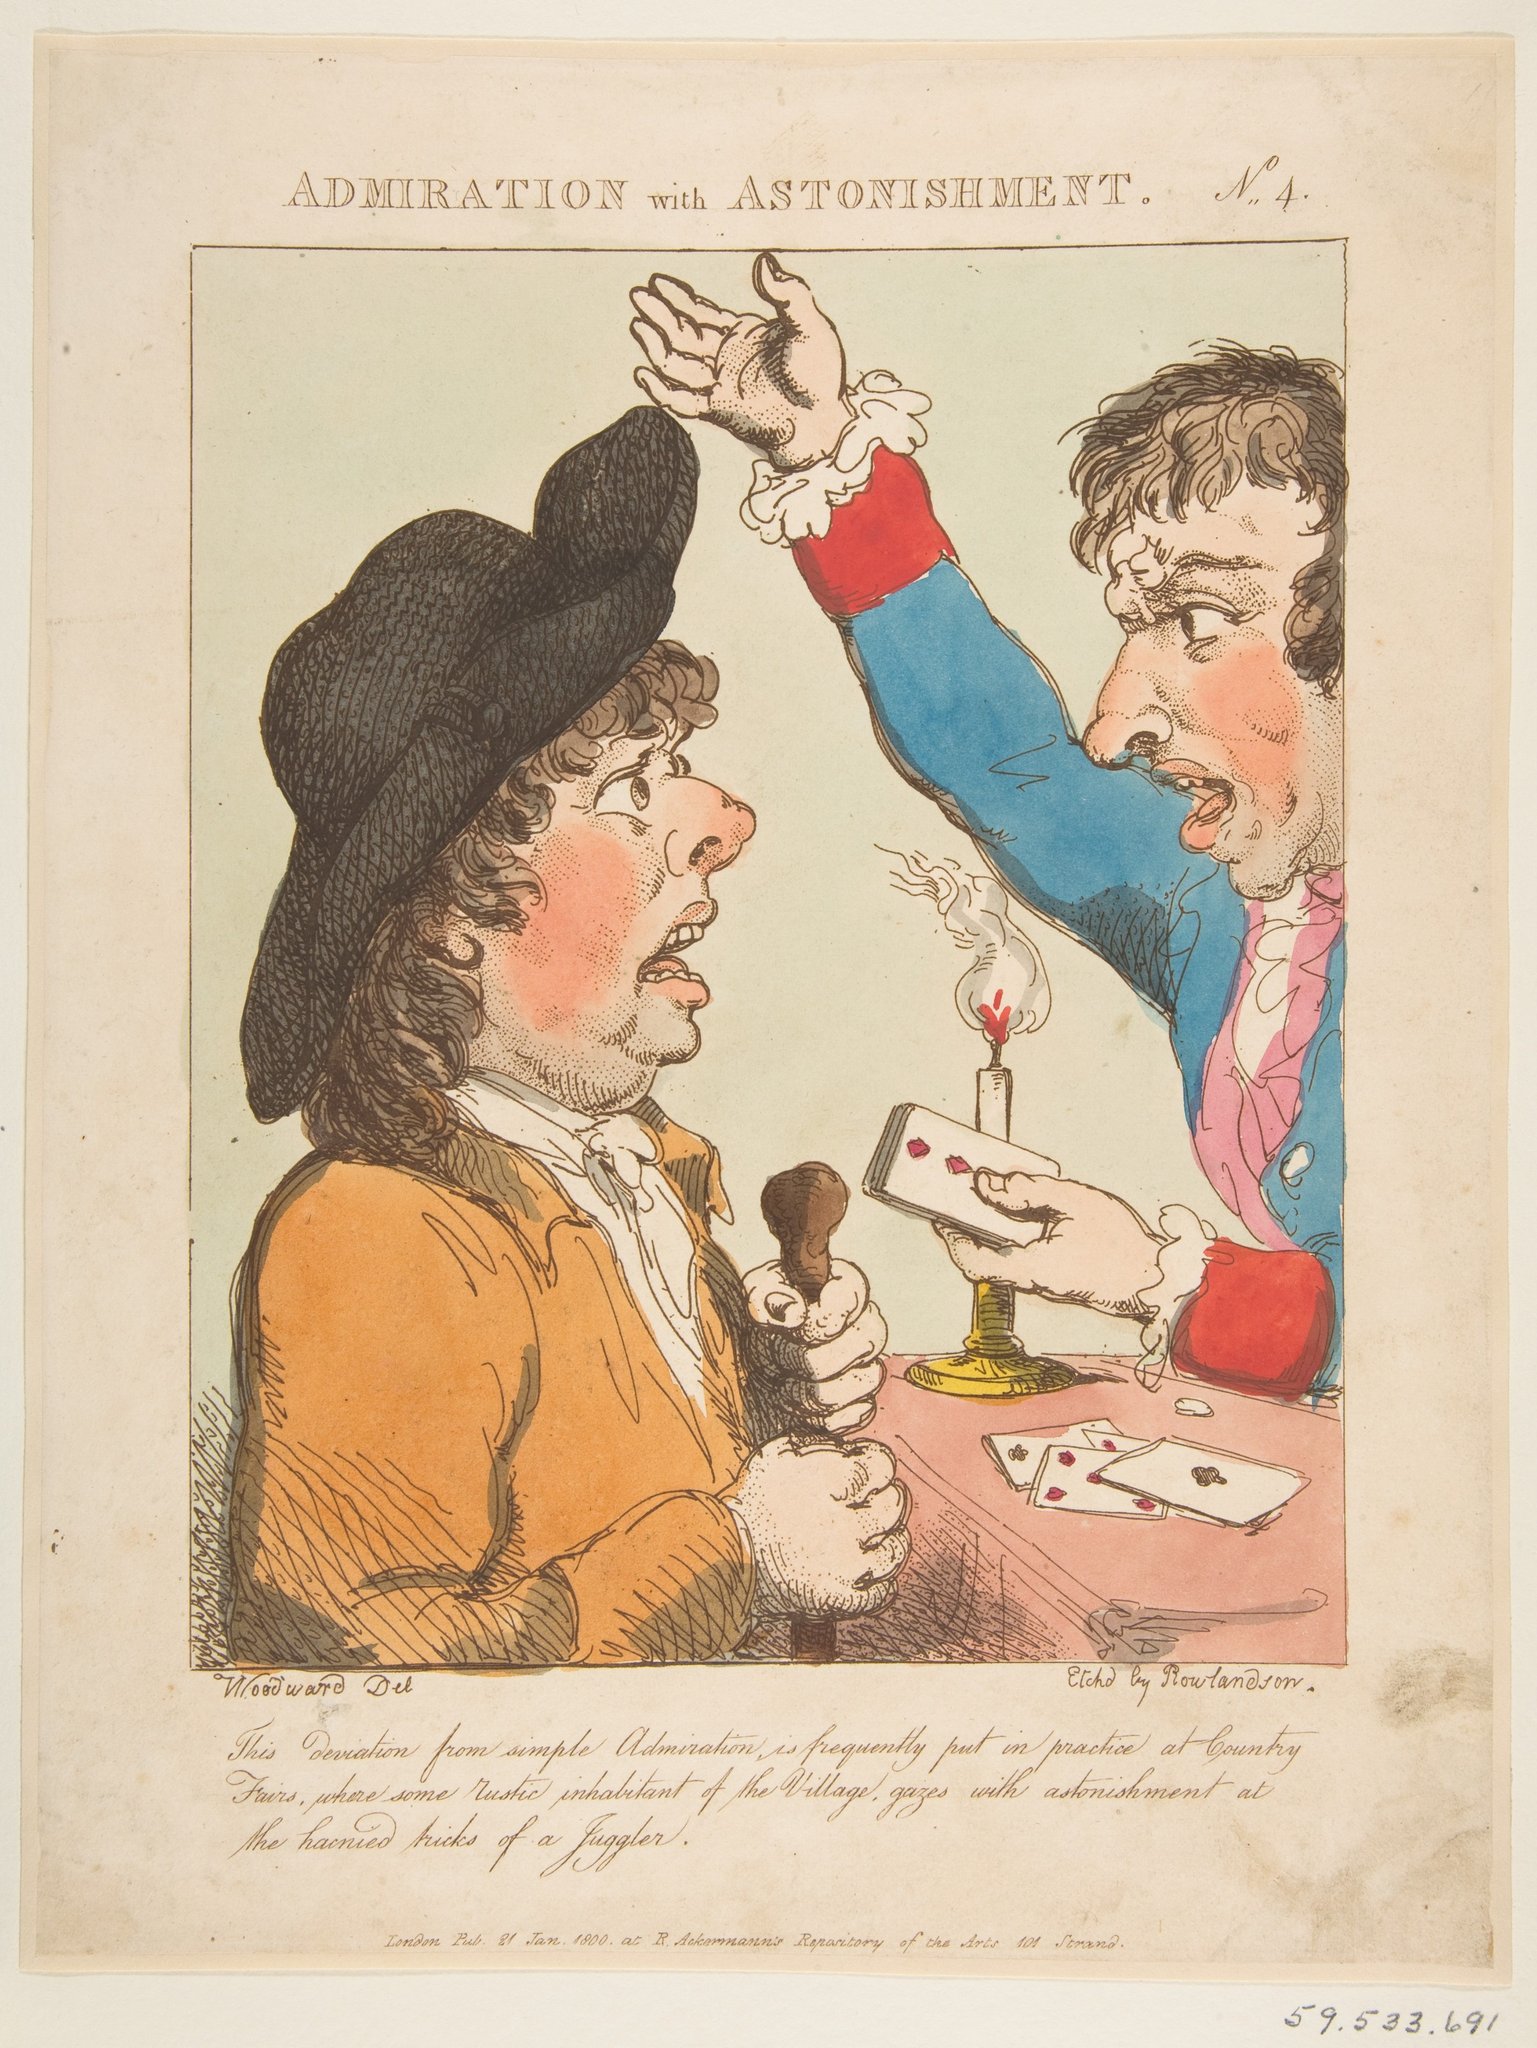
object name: print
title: Admiration with Astonishment (Le Brun Travested, or Caricatures of the Passions)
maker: thomas rowlandson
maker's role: artist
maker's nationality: british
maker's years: 1757-1827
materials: ink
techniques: etching, printing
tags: satire,men,women,playing cards